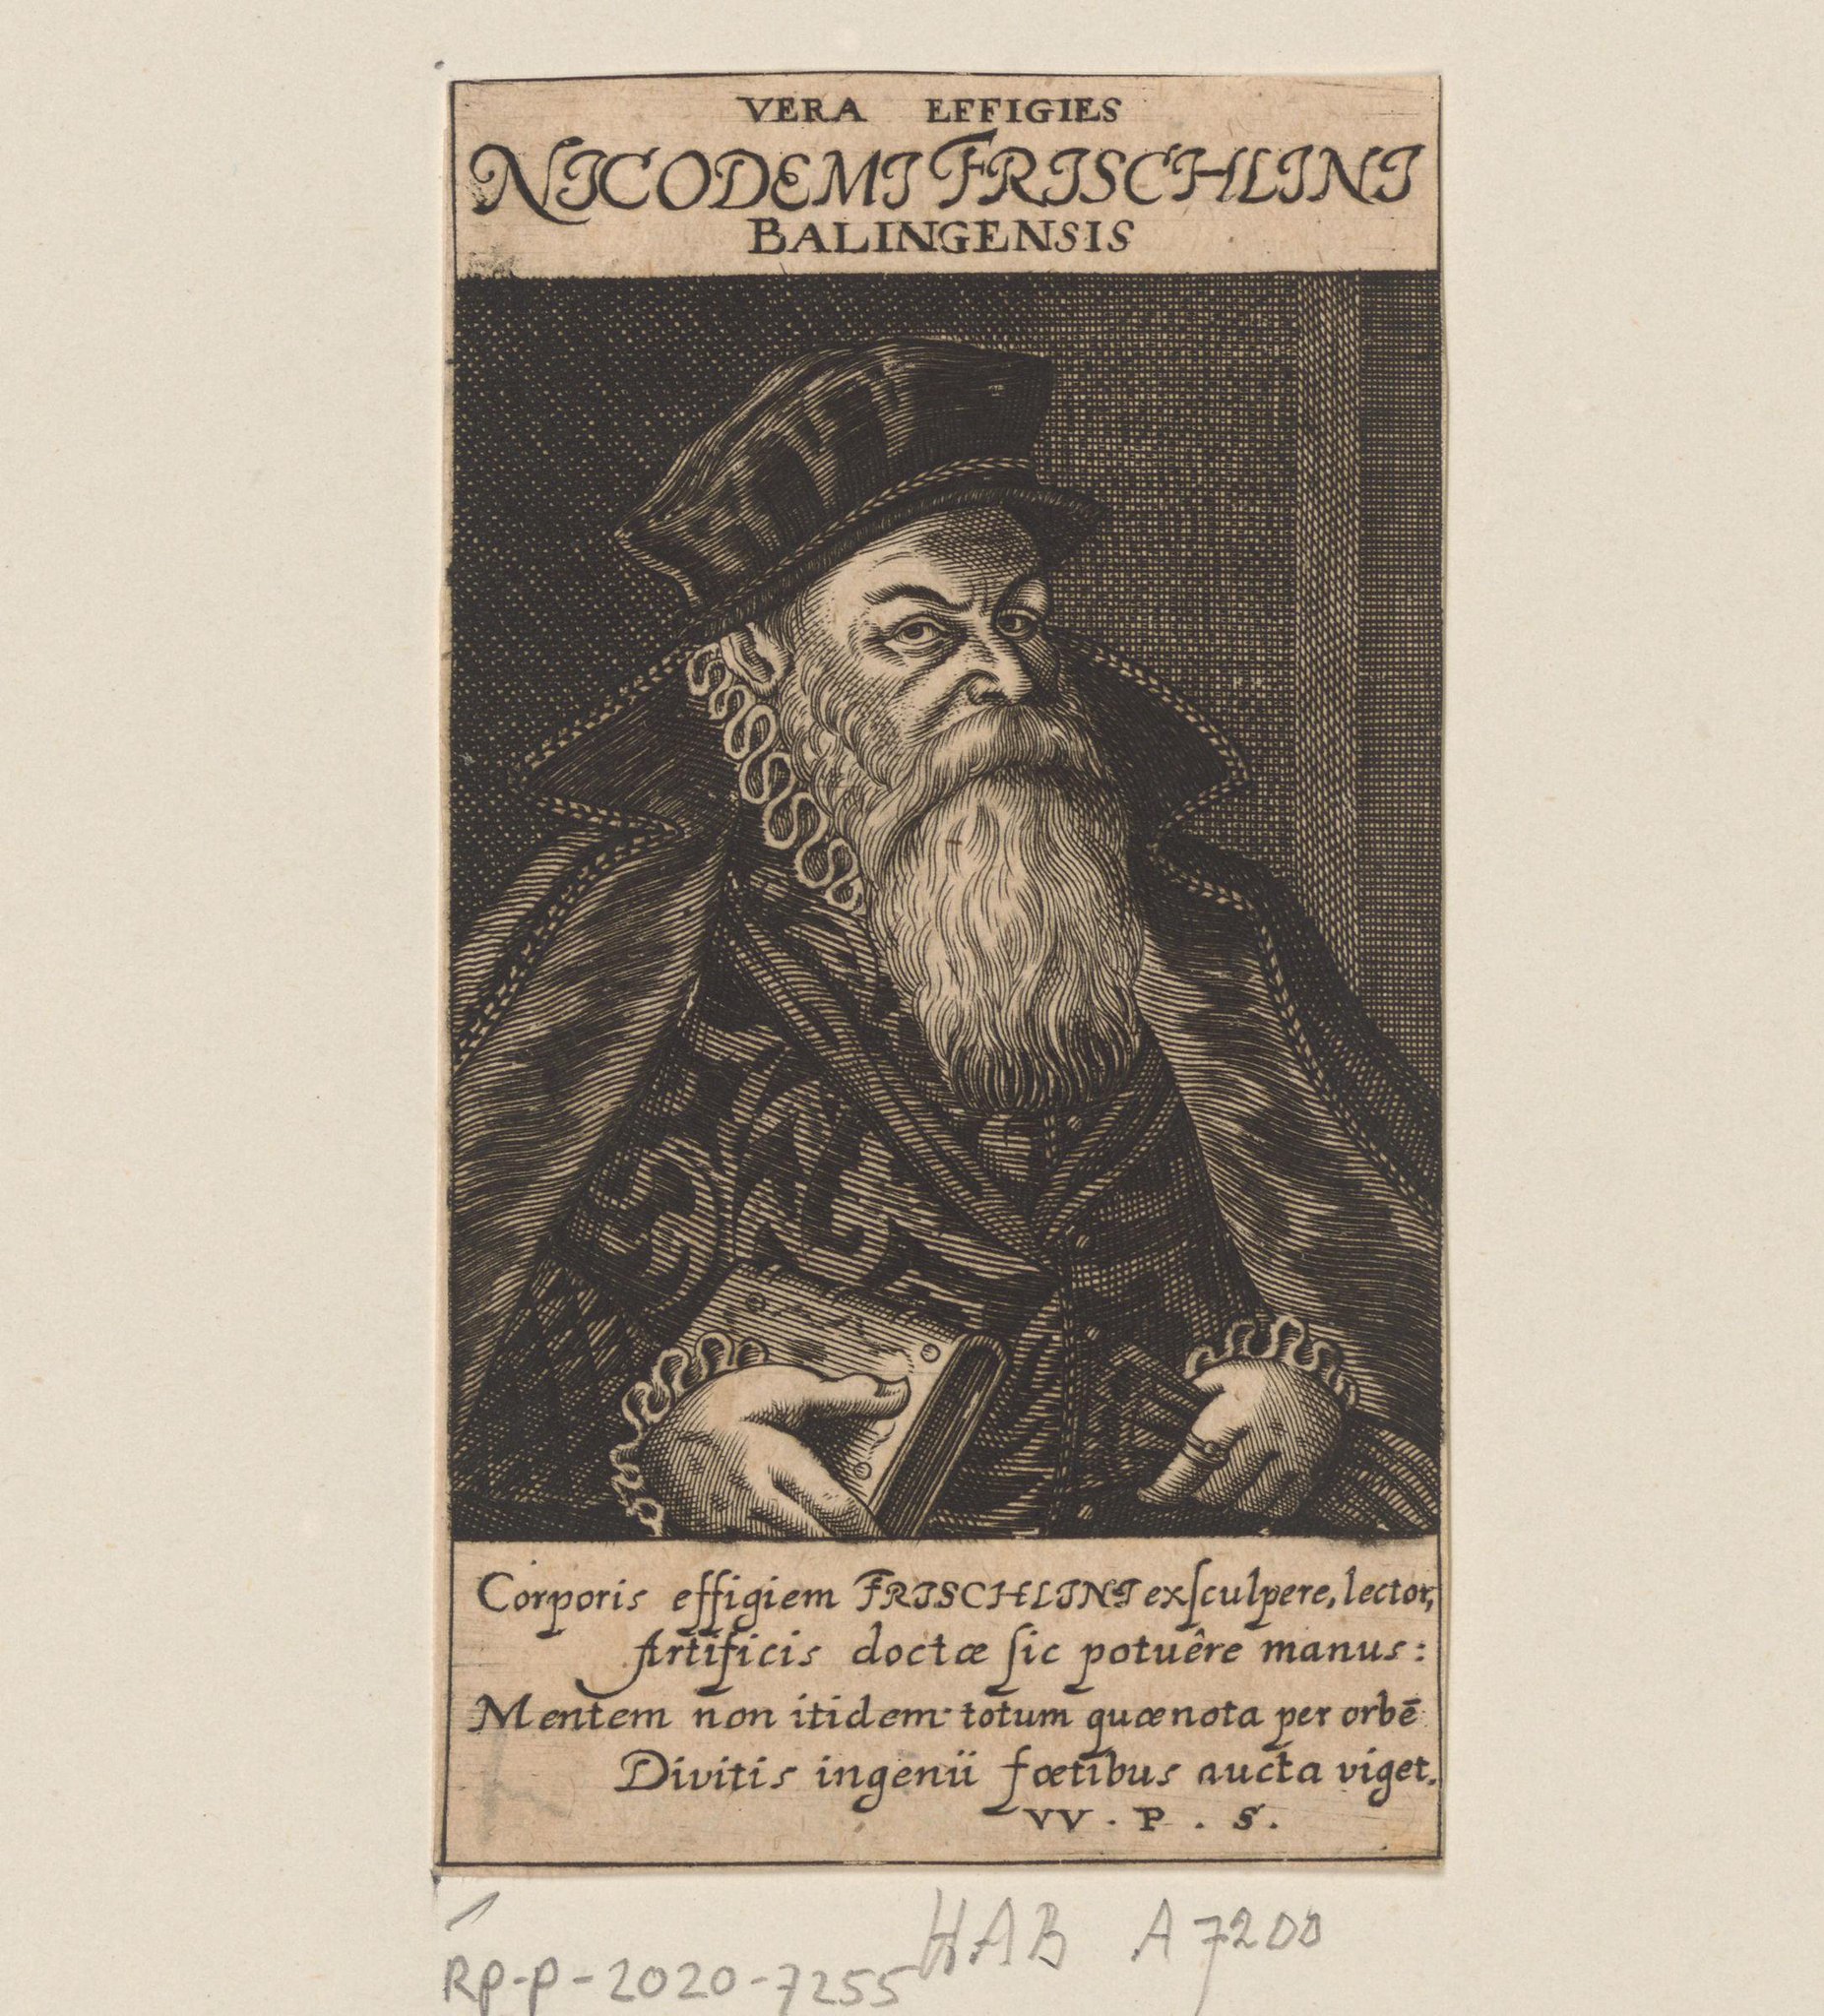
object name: print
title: Portret van Philipp Nicodemus Frischlin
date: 1620-1700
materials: paper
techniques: engraving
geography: germany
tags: historical persons, book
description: Met vierregelig onderschrift in het Latijn.